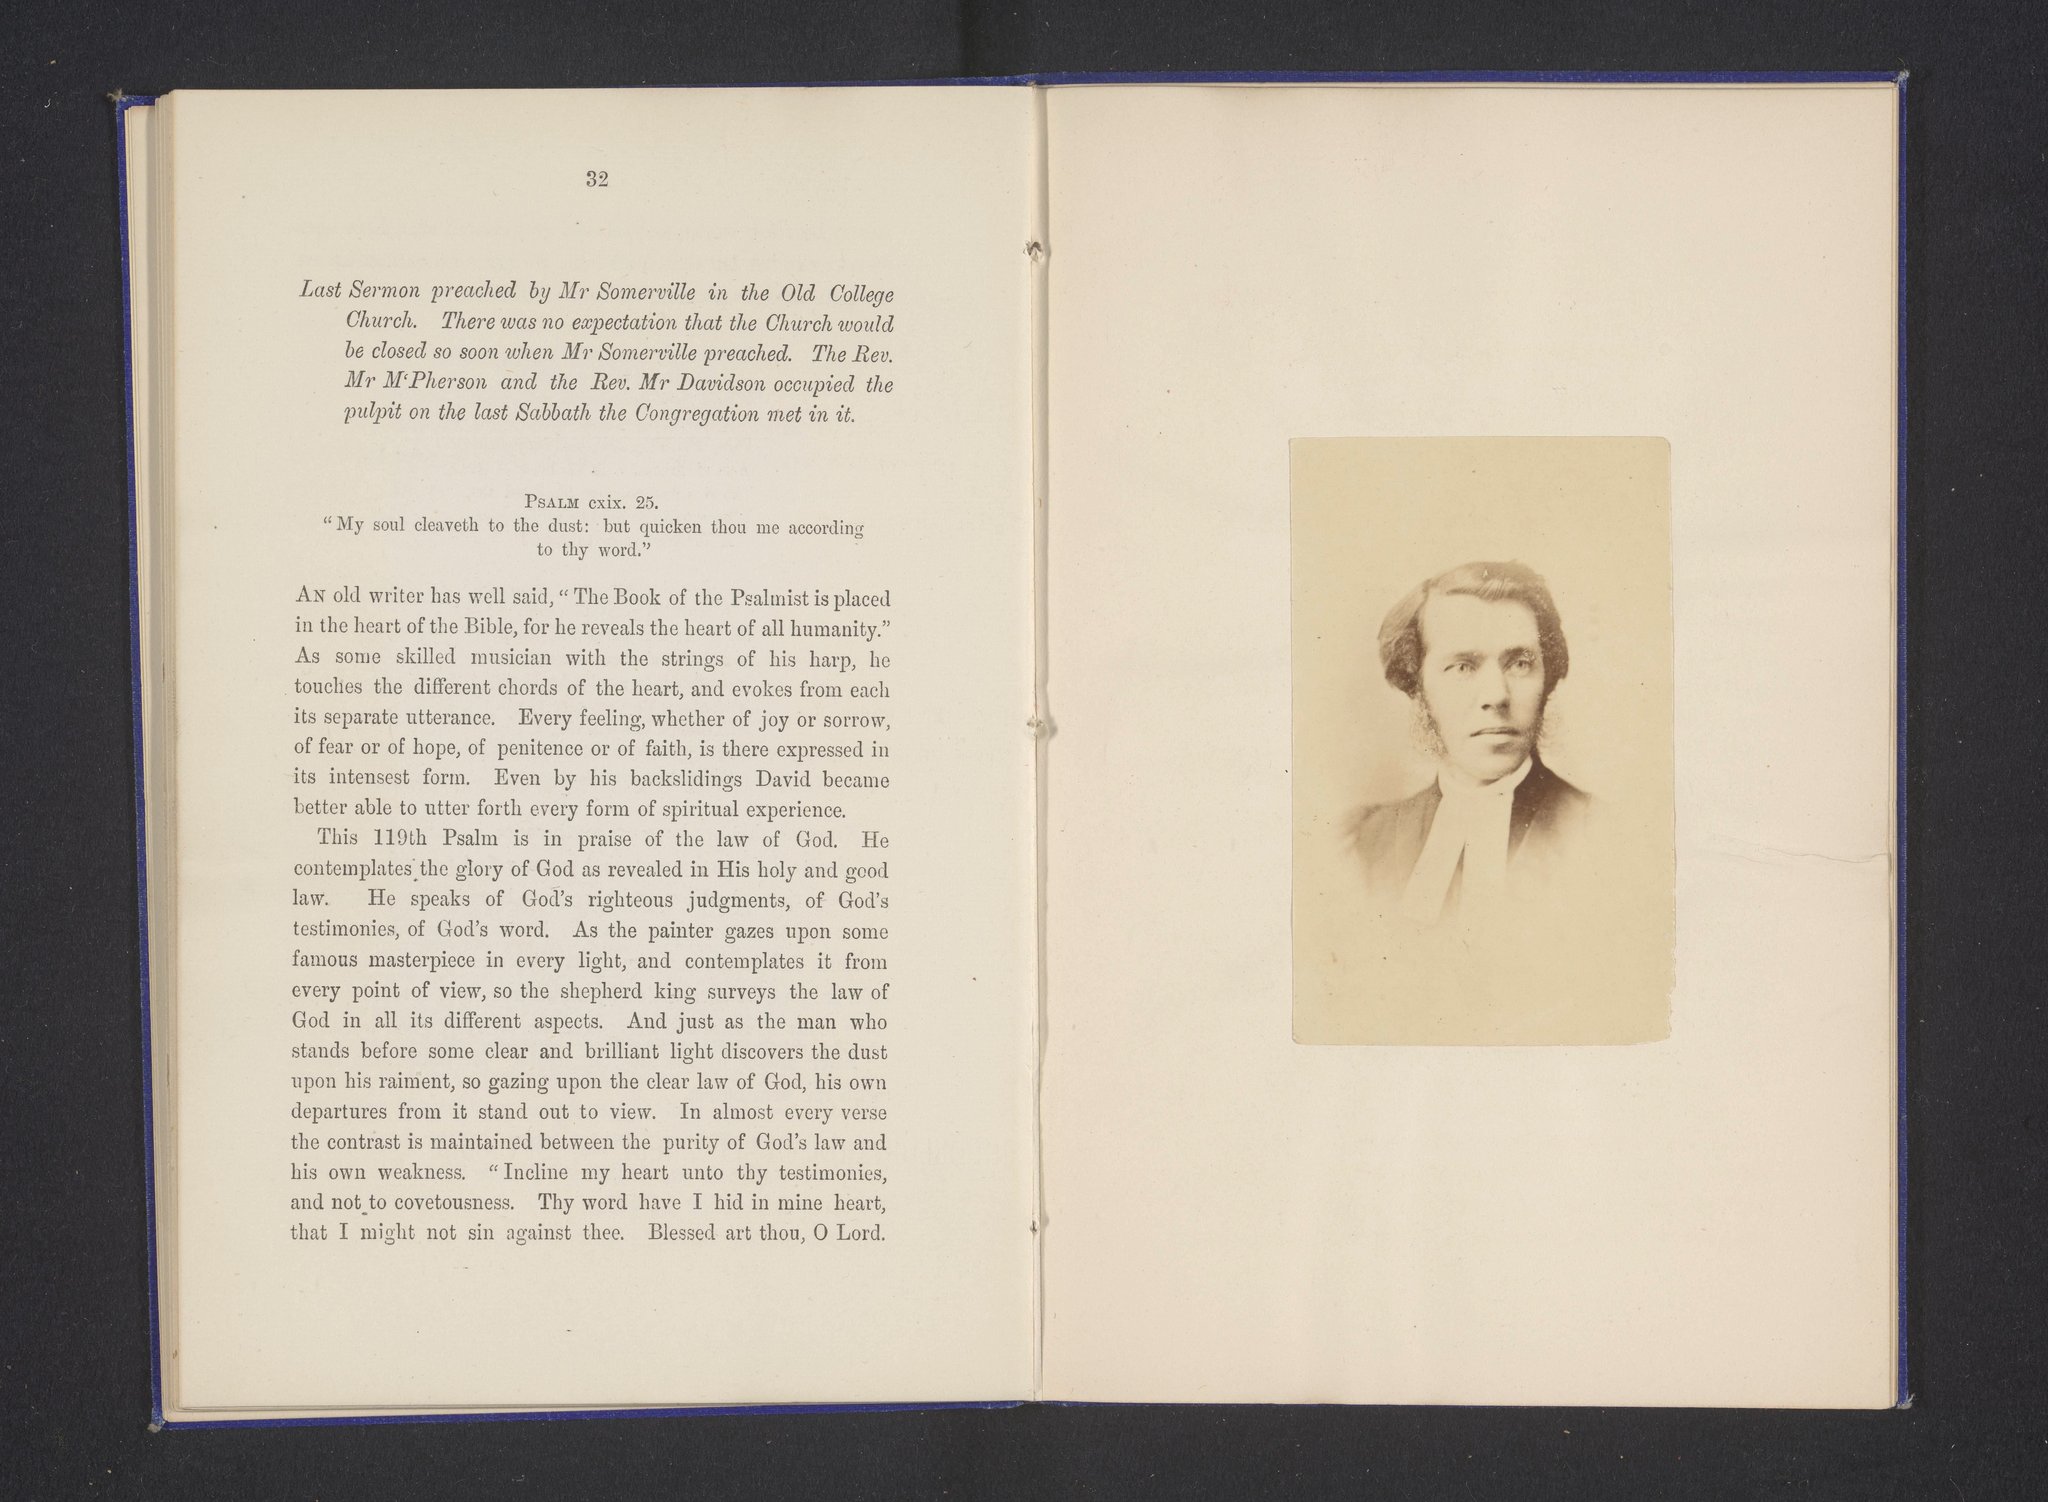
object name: photograph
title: Portret van een onbekende man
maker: Anonymous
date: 1866-1876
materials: photographic support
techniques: albumen print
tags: adult man